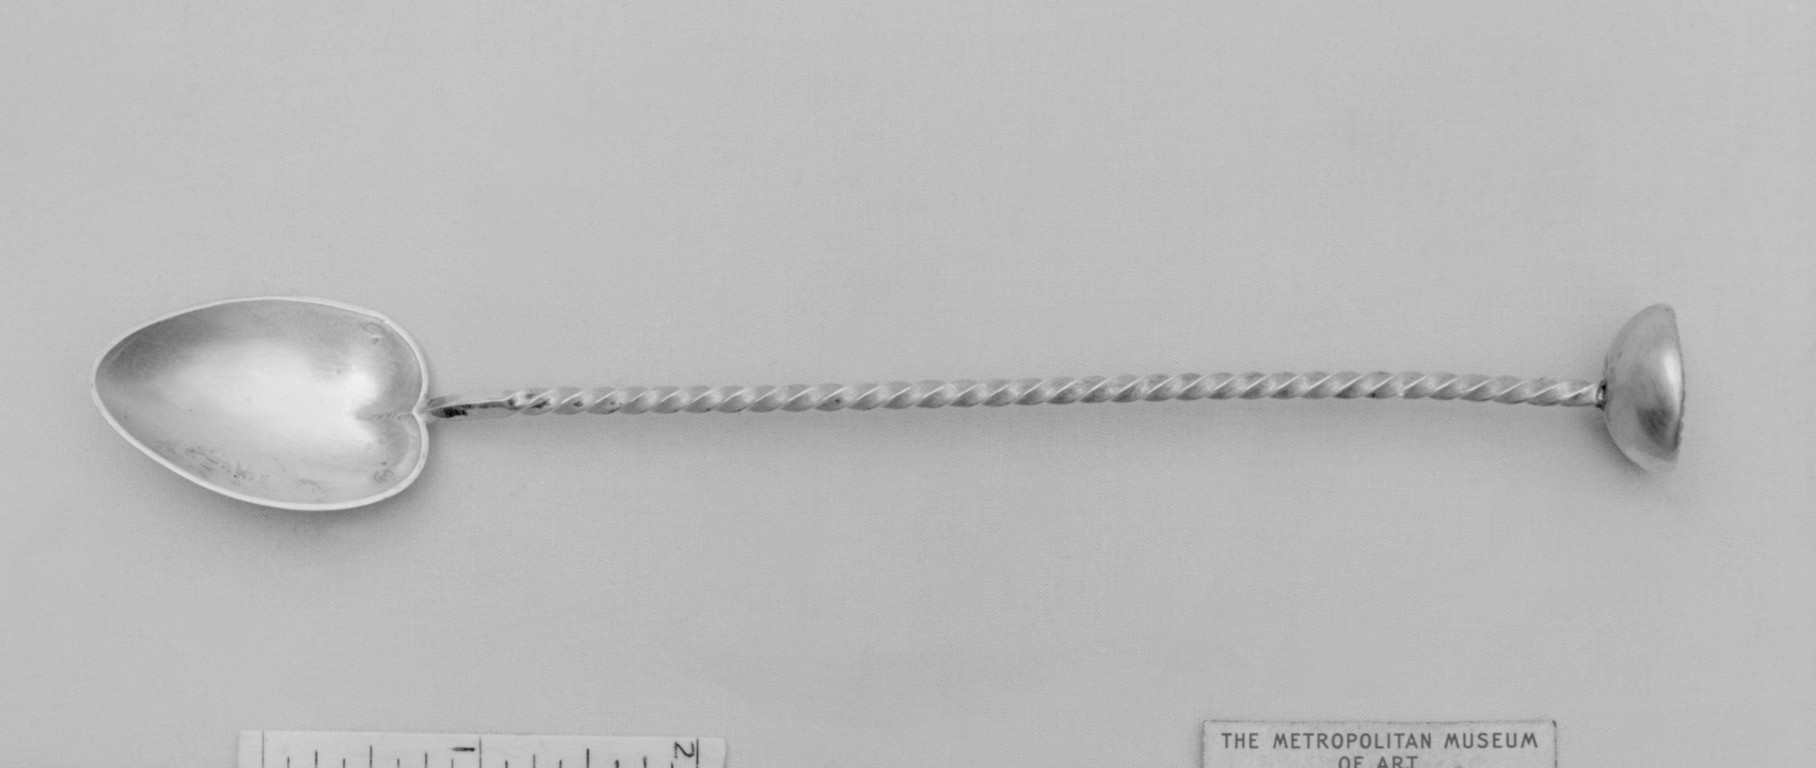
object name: spoon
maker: françois-pamphile jozan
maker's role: maker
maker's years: 1794-1877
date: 1819-1838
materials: silver